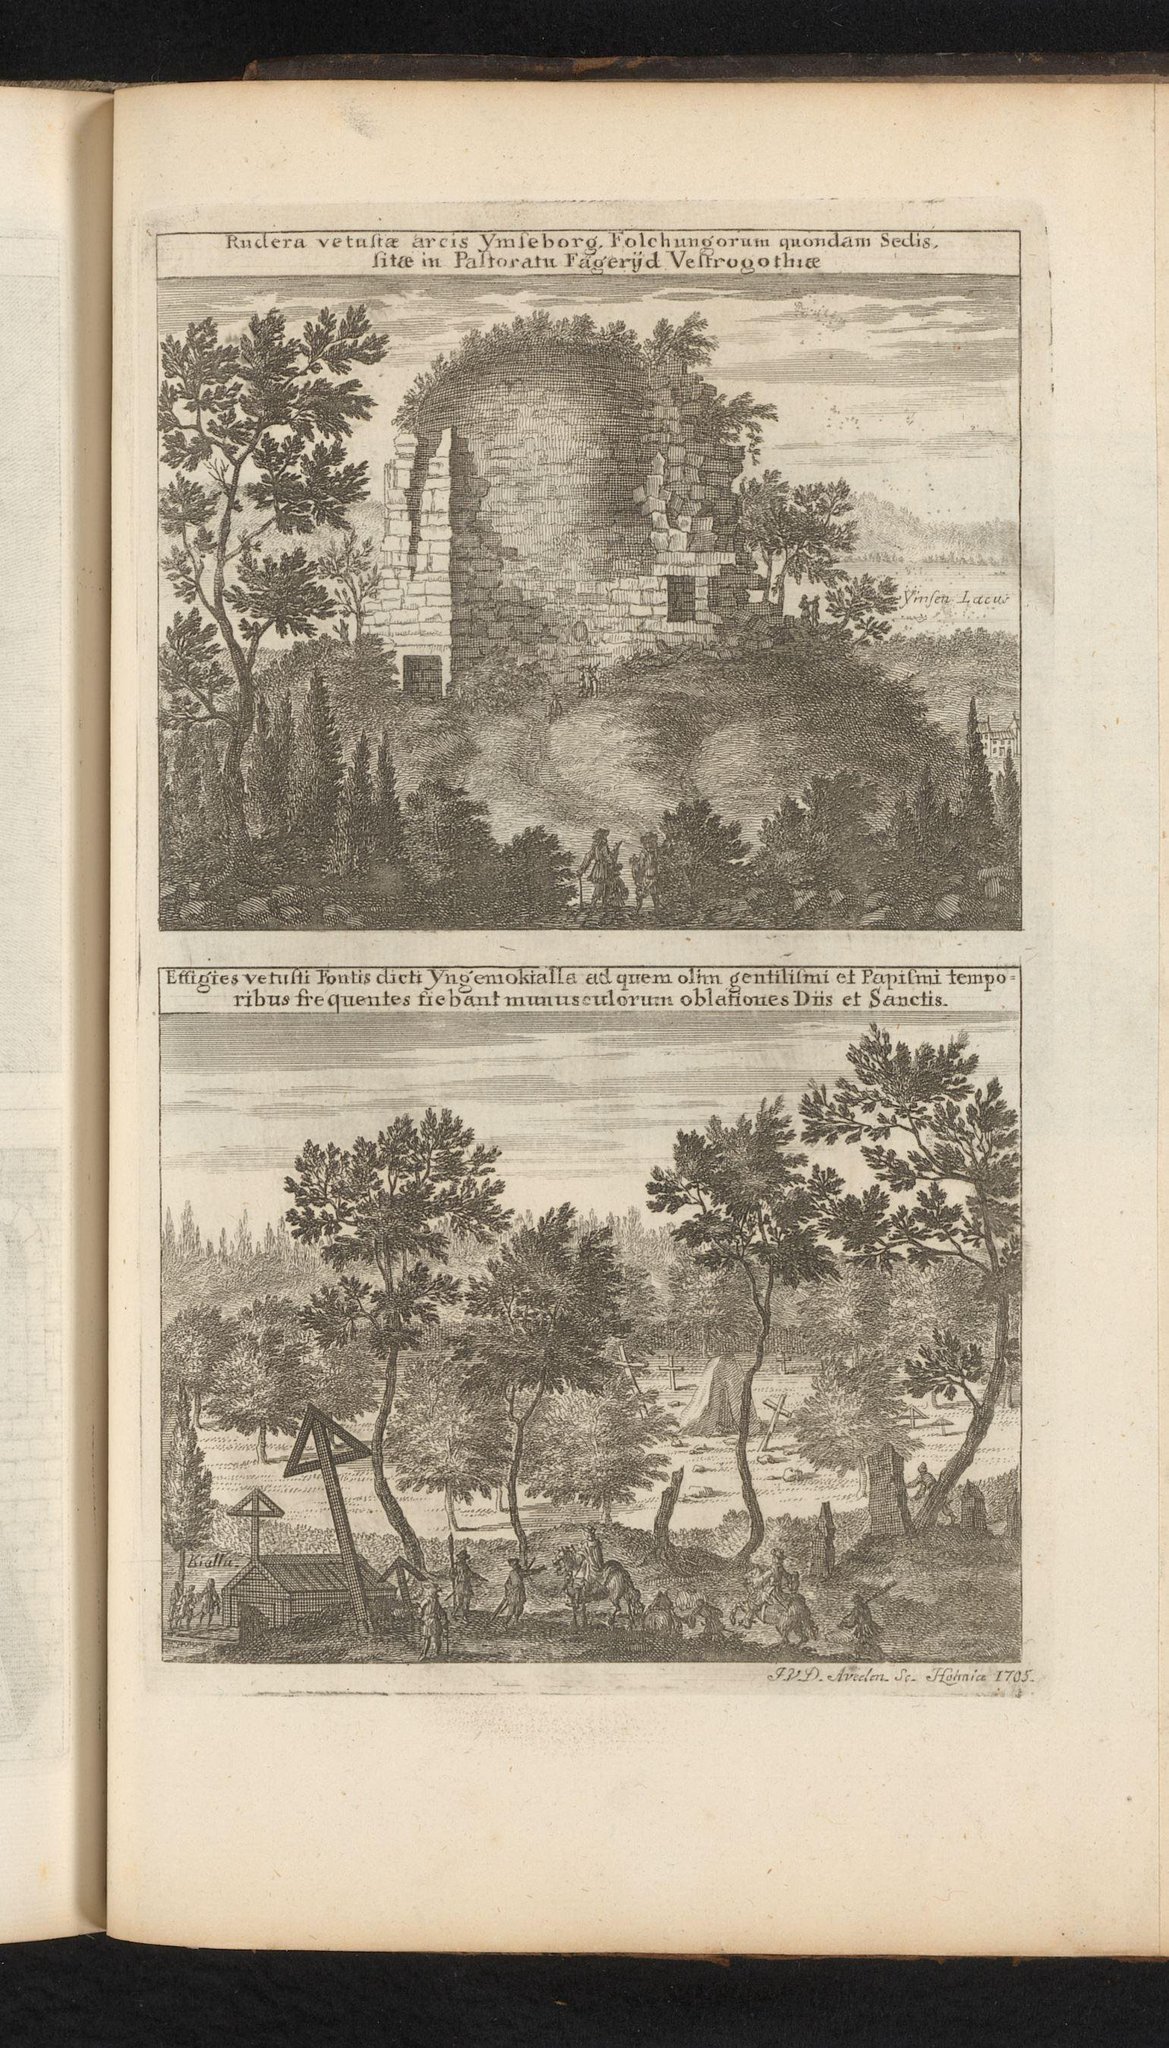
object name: album leaf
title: Rudera vetustae arcis Ymseborg, Folchungorum quondom Sedis, sitae in Pastoratu Fagerijd Vestrogothiae / Effigies vetusti fontis dicti Yngemo kiälla ad quem olim gentilismi et Papismi temporibus frequentes fiebant munusculorum oblationes Diis et Sanctis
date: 1705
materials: paper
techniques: etching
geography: stockholm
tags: landscape with ruins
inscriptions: date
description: Kungliga Biblioteket, 'Suecia': http://www.kb.se/samlingarna/Kartor-bilder/Suecia-antiqua/ (geraadpleegd november 2016).